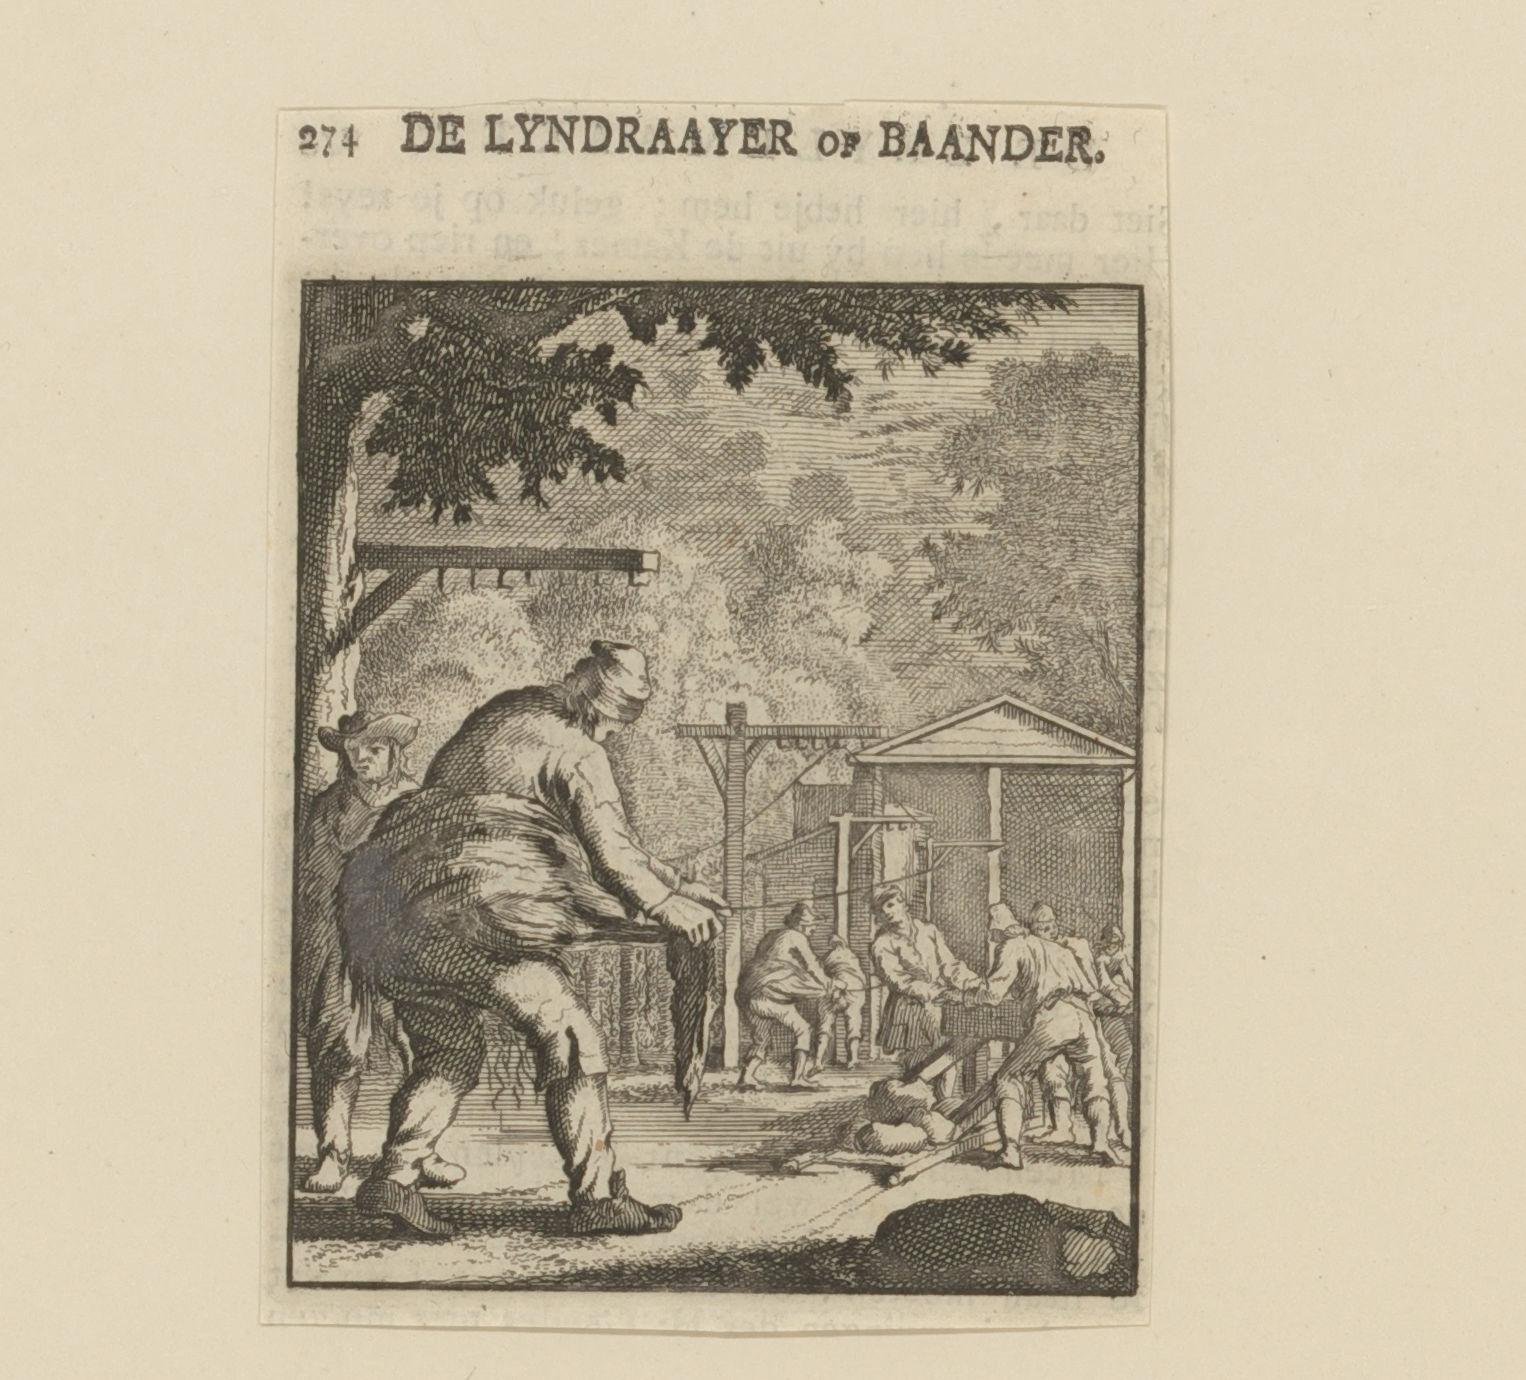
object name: print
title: Touwslager aan het werk op de lijnbaan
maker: Anonymous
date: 1719-1759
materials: paper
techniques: etching, letterpress printing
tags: rope-making, handicrafts, craftsman at work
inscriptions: stamp, collector's mark: Lugt 1641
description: Prent met andere letterzetting gebruikt in: St. Clara, Abraham van. Iets voor allen. [Vertaald door] J. le Long. Amsterdam: Janssoons van Waesberge, 1719, dl. 2. En in: St. Clara, Abraham van. Iets voor allen. [Vertaald door] J. le Long. Amsterdam: Jan Roman de Jonge, 1741, dl. 2. En in: St. Clara, Abraham van. Iets voor allen. [Vertaald door] J. le Long. Amsterdam: Jan Roman, 1759, dl. 2. Huidige prent uit een andere editie. Naar een prent van: Jan Luyken.